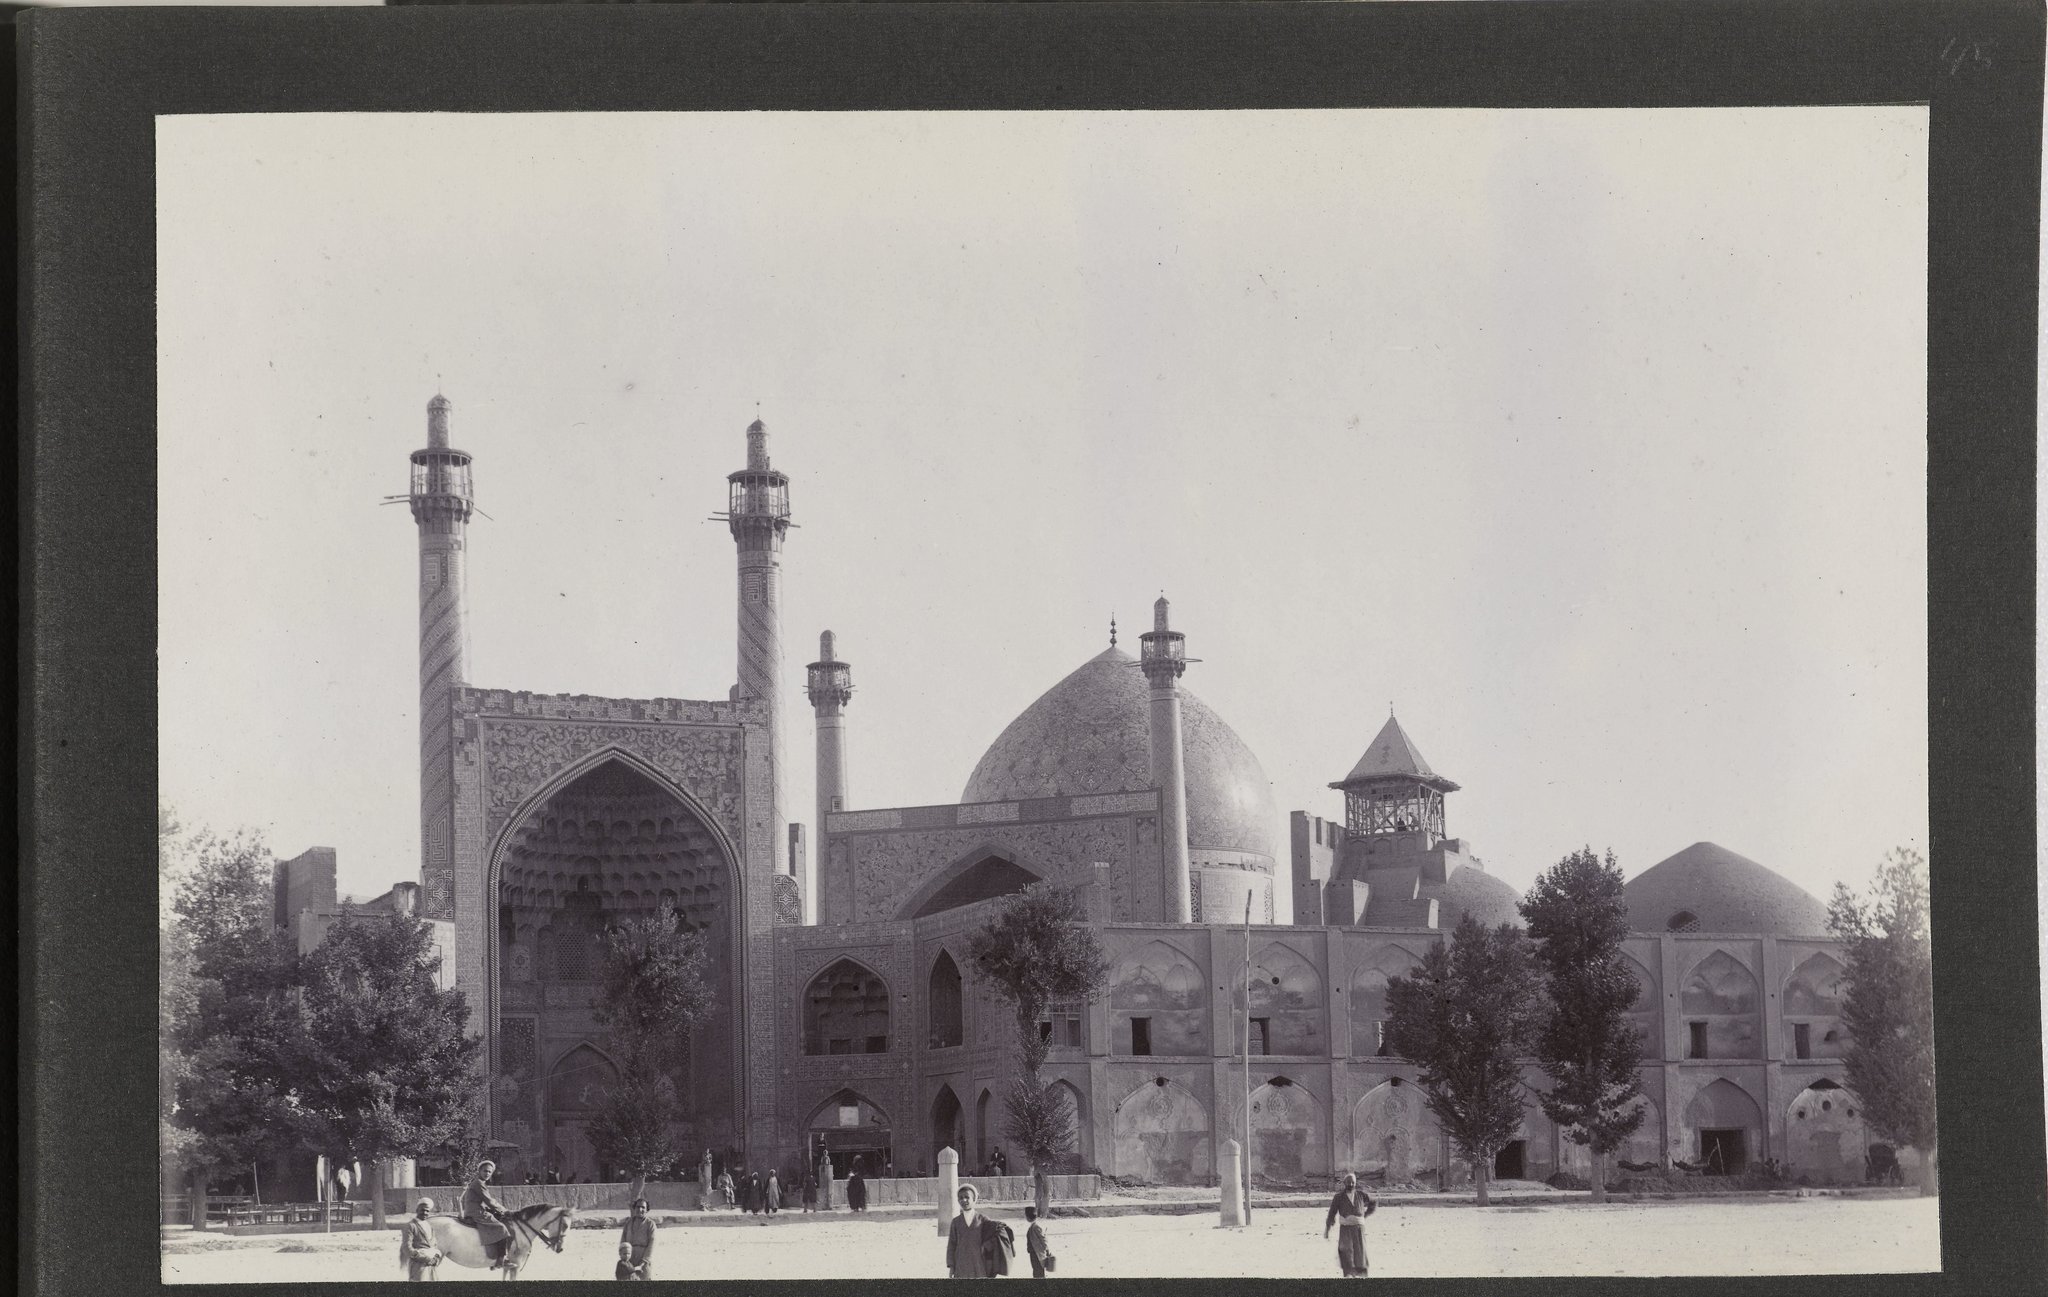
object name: photograph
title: Moskee aan het plein Naghsh-e Jahan, Isfahan, Perzië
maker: a.g.a. van eelde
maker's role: engineer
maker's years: 1862-1950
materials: cardboard, paper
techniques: gelatin silver print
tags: isfahan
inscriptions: number: ‘45.’